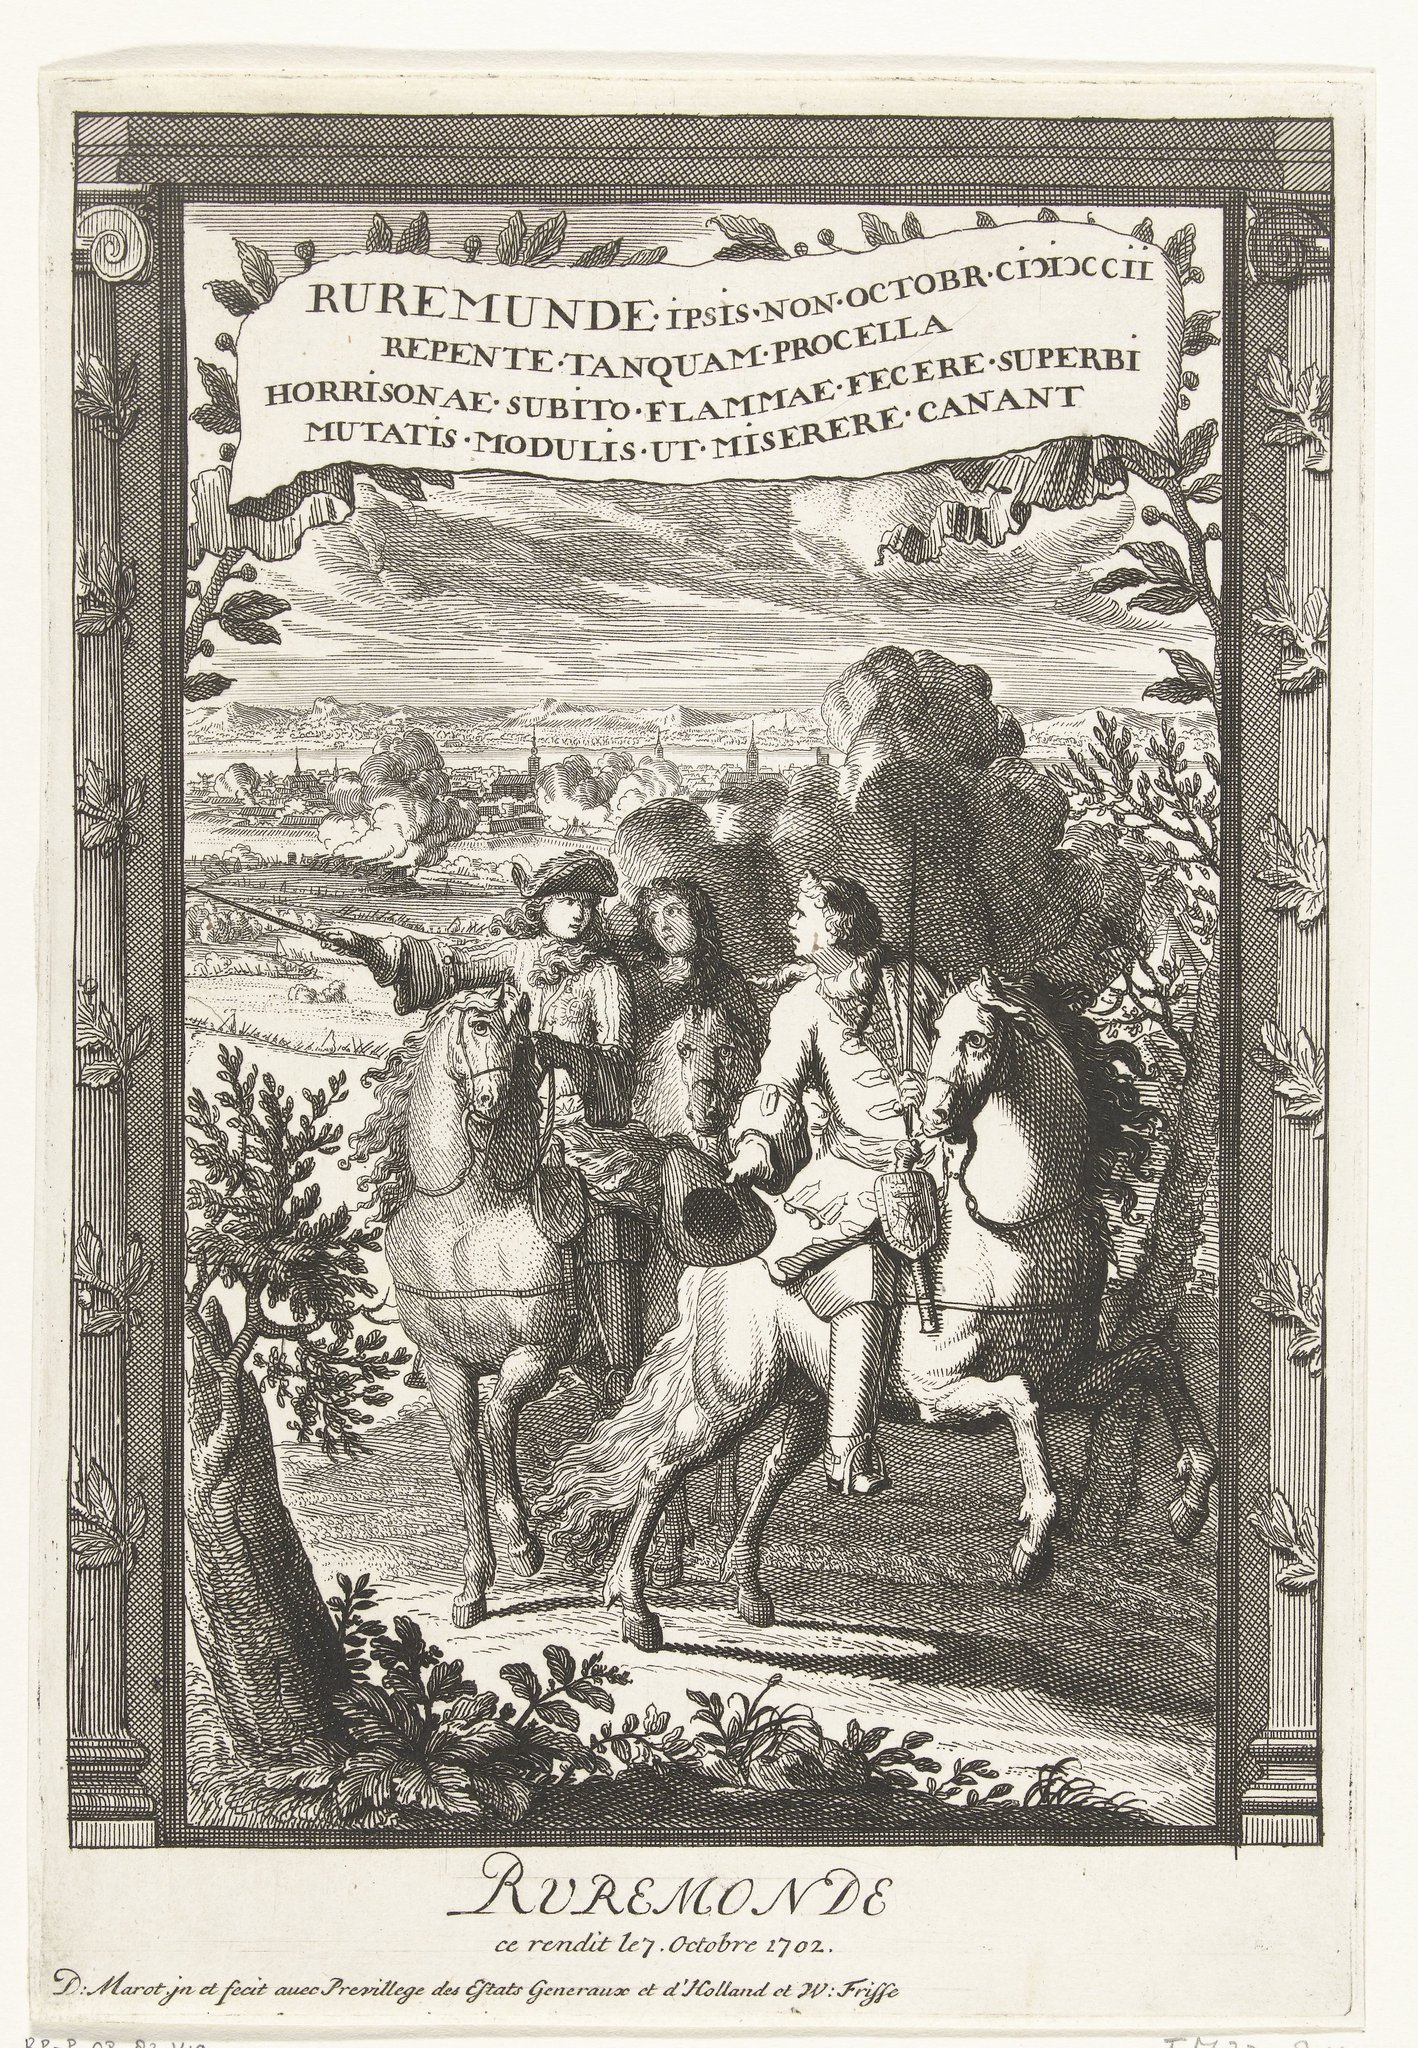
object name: print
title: Ruremonde ce rendit le 7. Octobre 1702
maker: daniël marot (i)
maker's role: draughtsman, print maker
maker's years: 1661-1752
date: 1702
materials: paper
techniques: etching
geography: northern netherlands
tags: capture of city (after the siege)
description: Paneel met een voorstelling van de overwinning te Roermond op 7 oktober 1702. Onderdeel van de decoraties op de stellage met de Tempel van Mars tijdens het vuurwerk op de Hofvijver op 13 december 1702 te Den Haag. De Tempel van Mars was versierd met acht panelen met voorstellingen van overwinningen van de geallieerden op Frankrijk en Spanje in het jaar 1702.